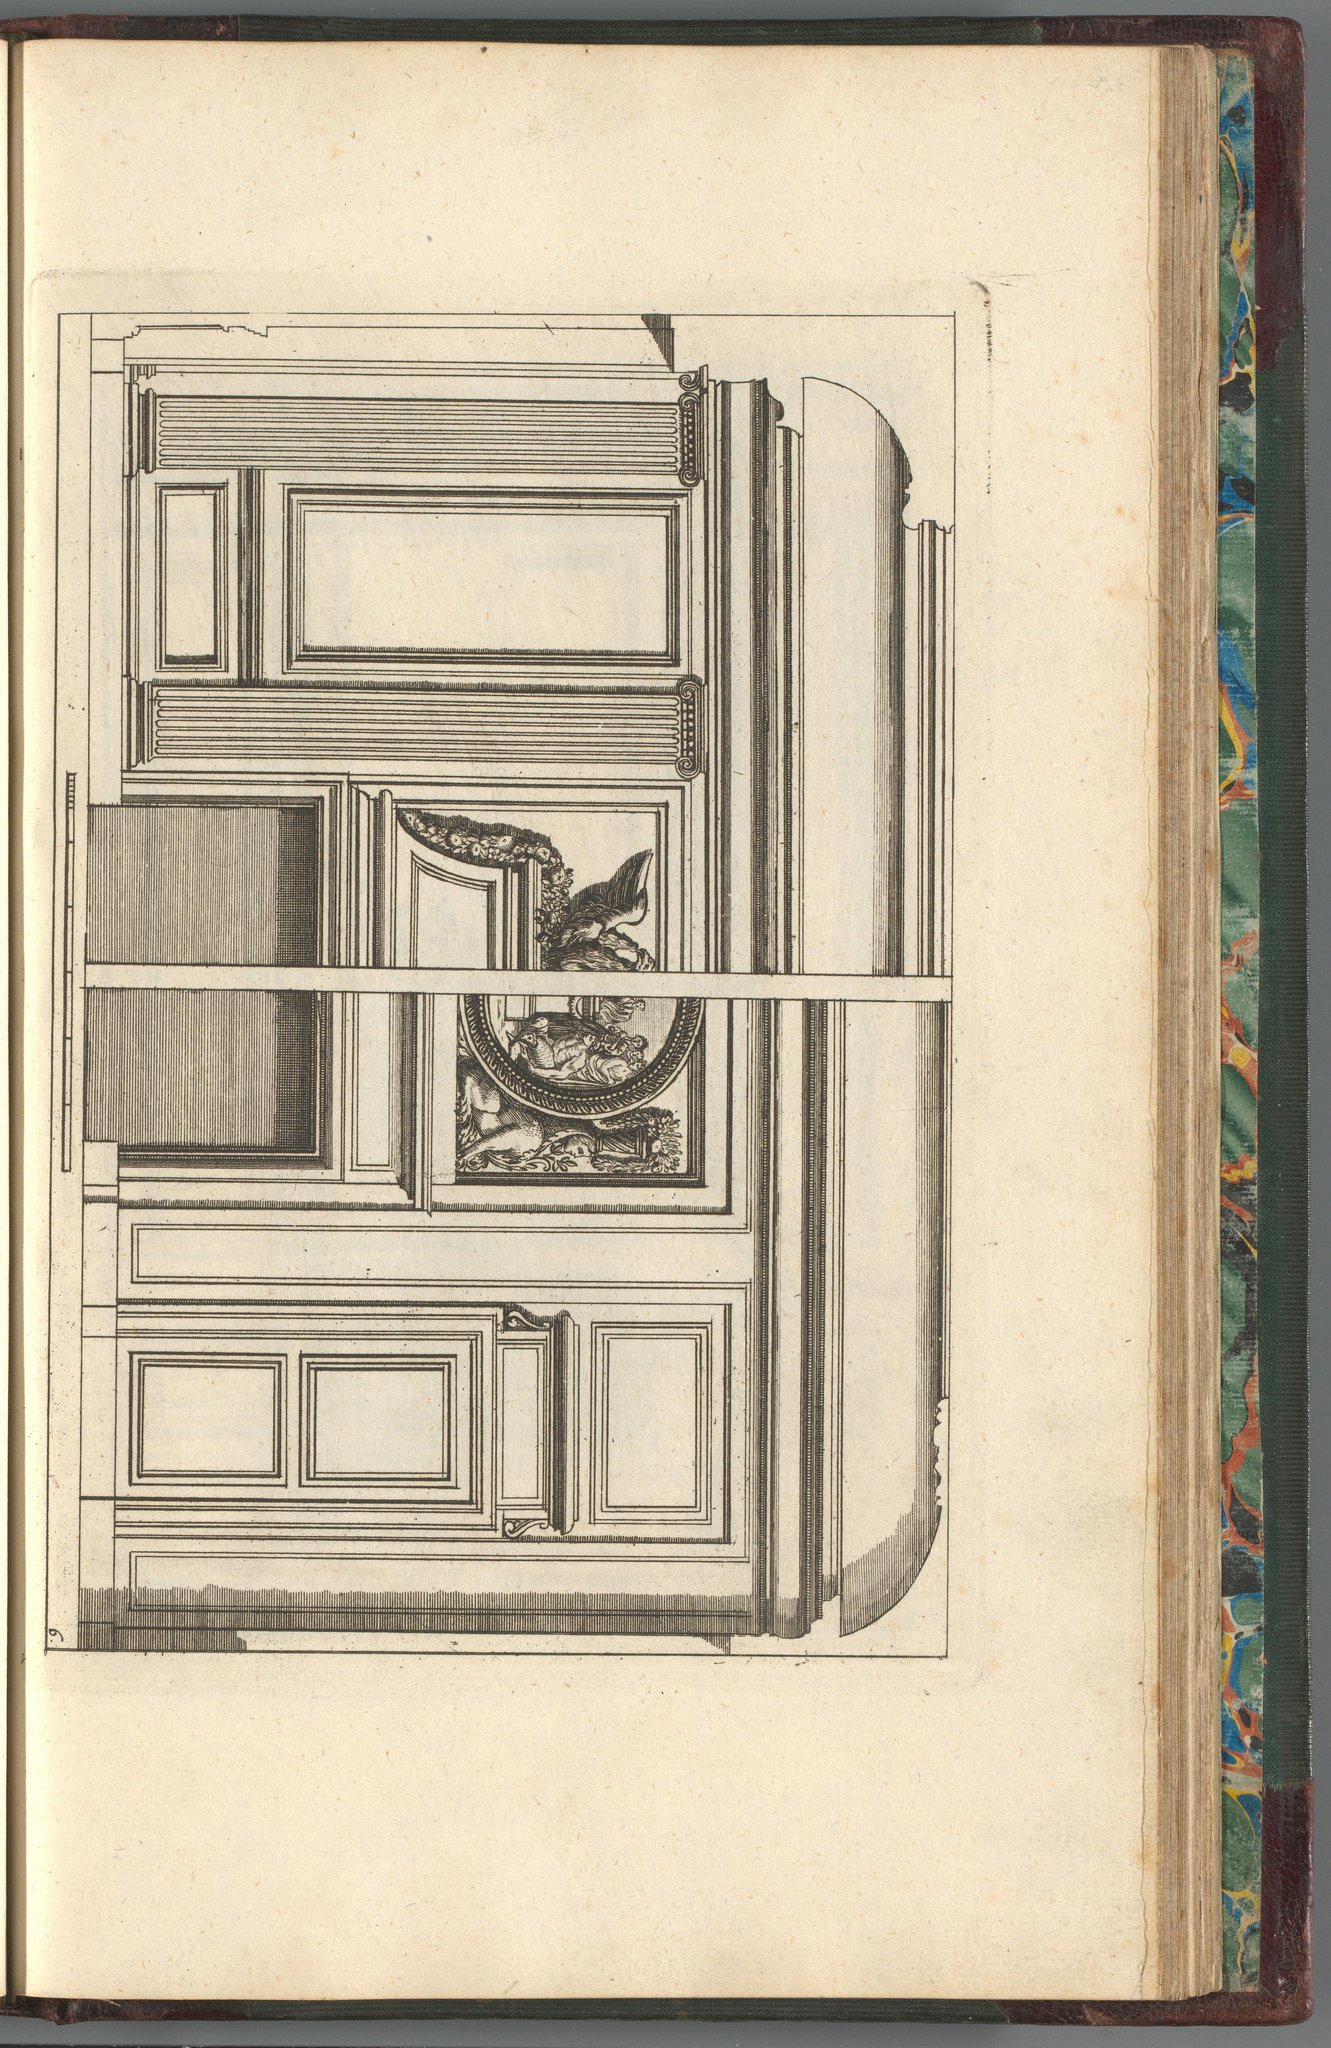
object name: print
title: Livre de Cheminees a la Moderne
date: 1686-1724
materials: paper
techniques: etching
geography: augsburg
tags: ornaments ~ art, chimney-piece, mantelpiece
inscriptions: number: ‘6.’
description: Ontwerp van een schoorsteenmantel met een variant voor de rechterhelft. Zesde prent uit een serie van zes. Prent maakt deel uit van een album. Hoogstwaarschijnlijk kopie naar Frans origineel.